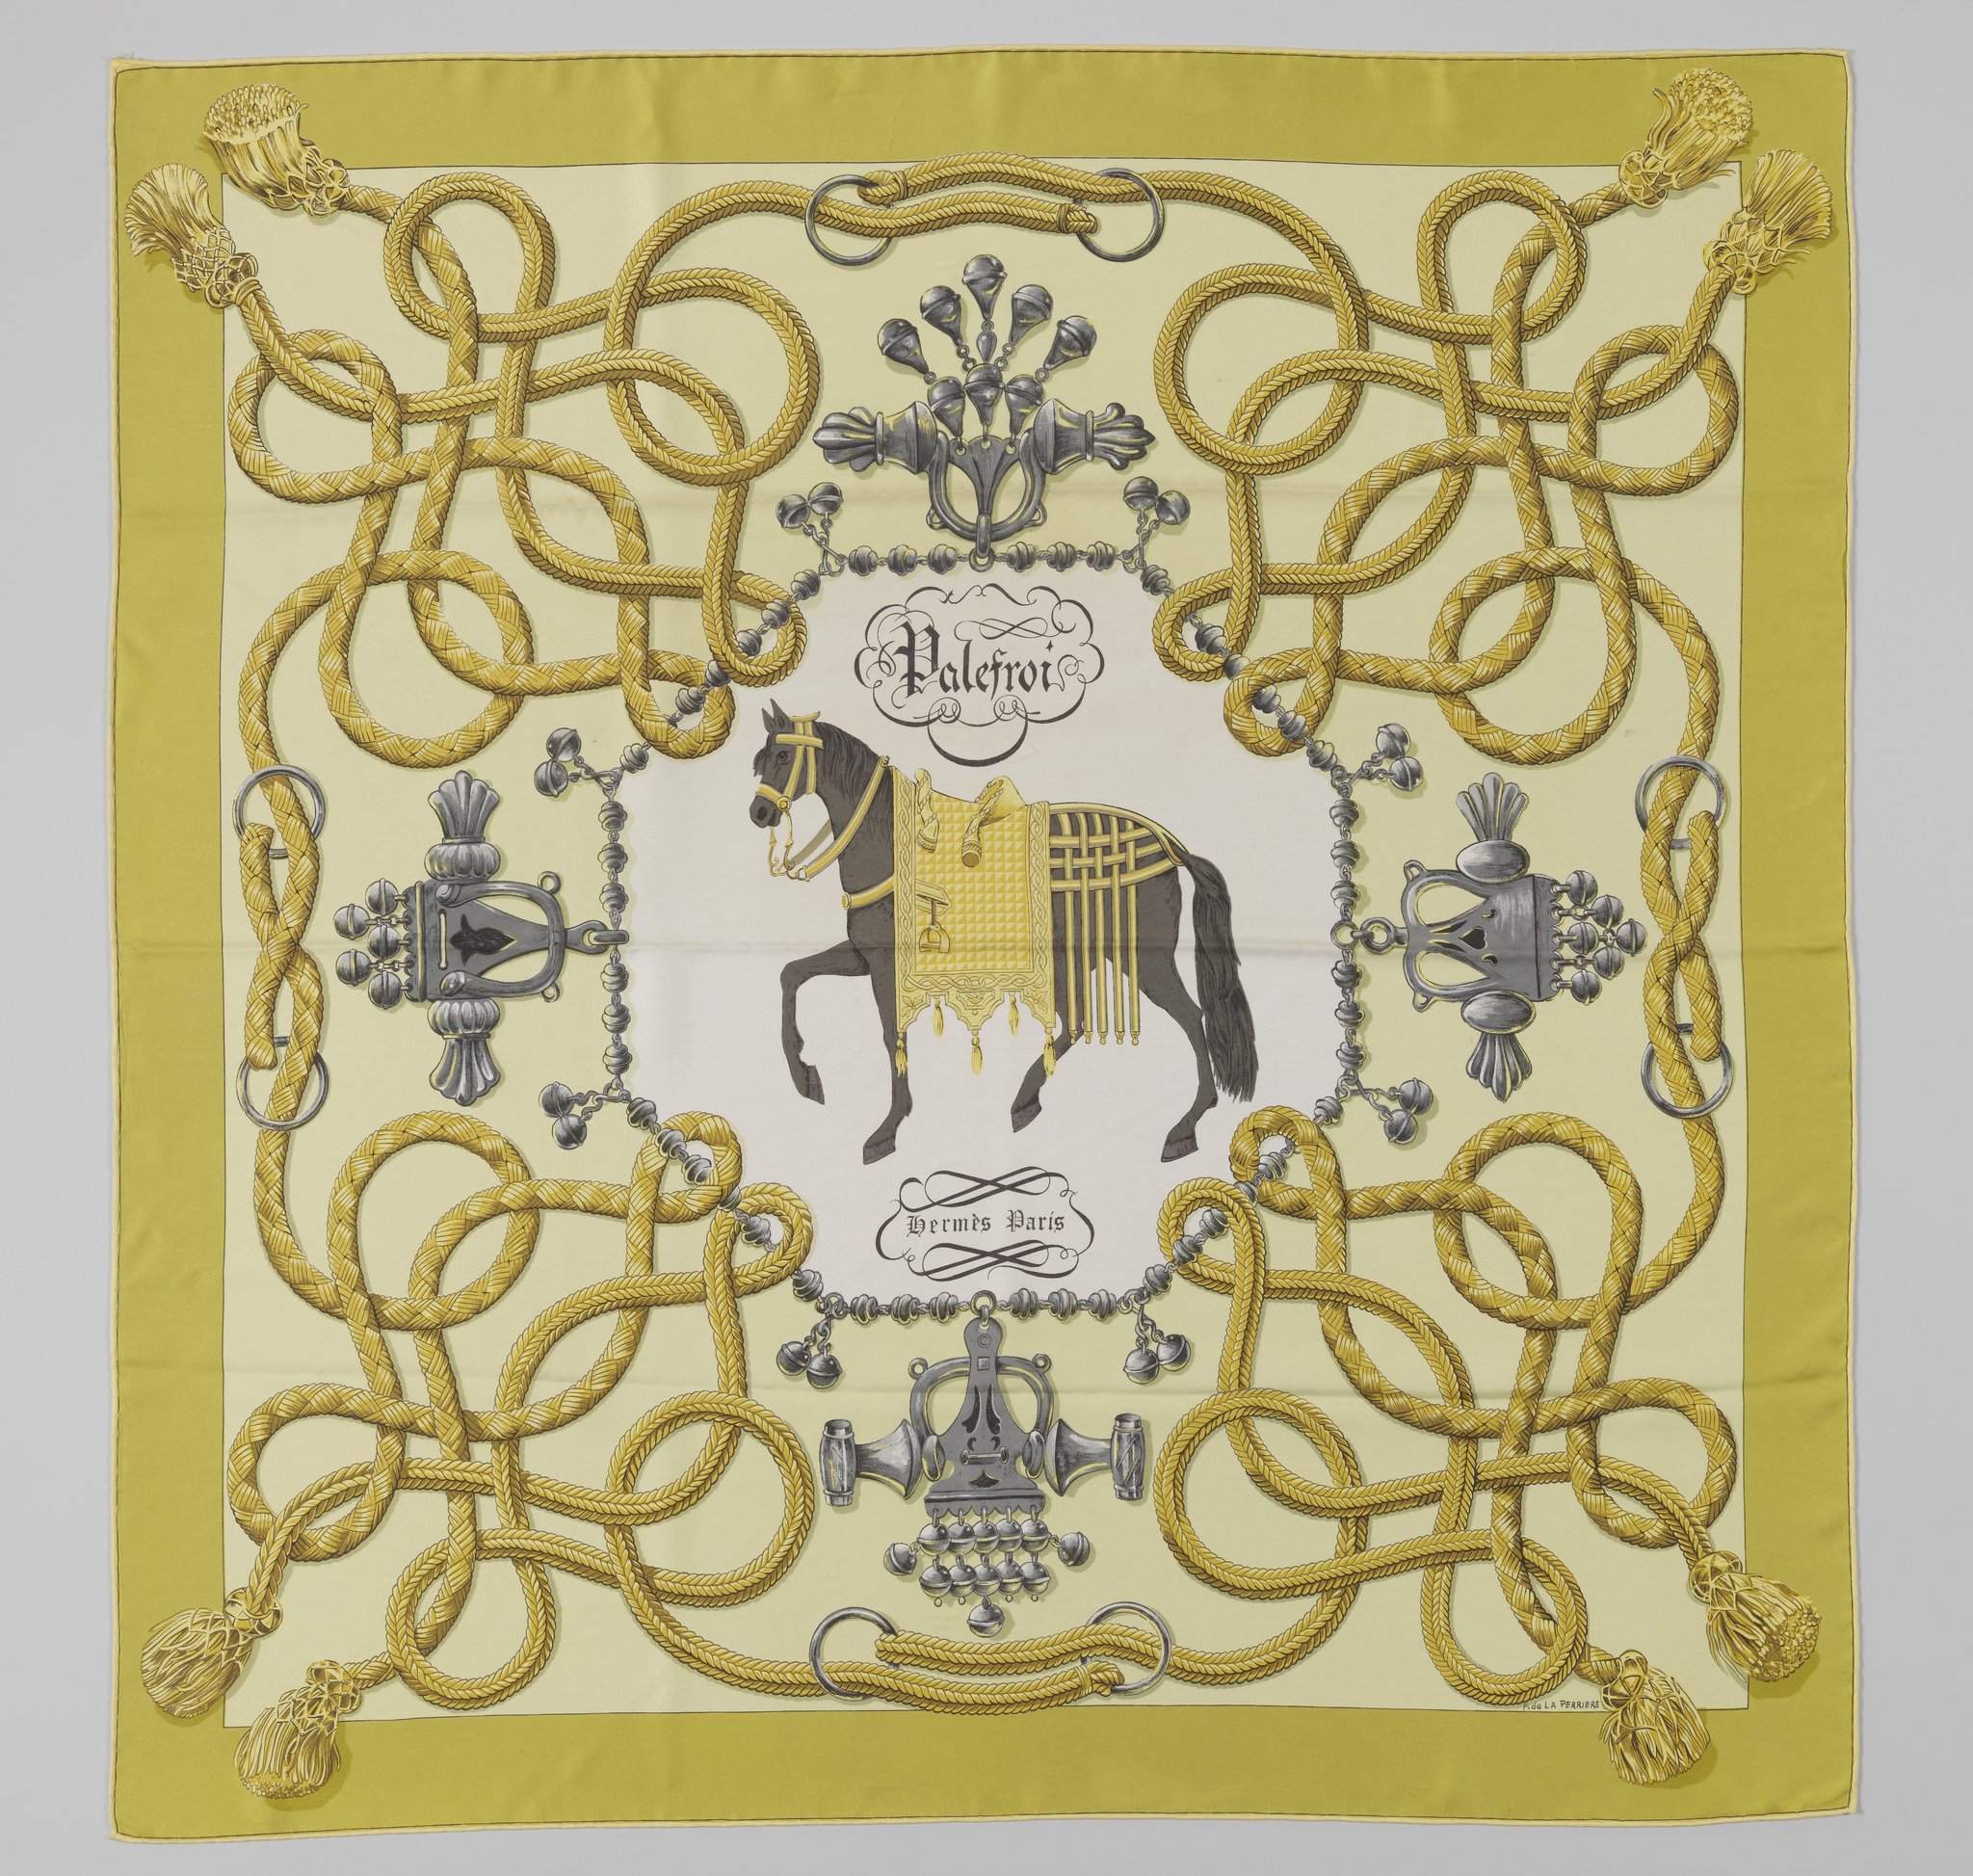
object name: clothing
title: Sjaal van gekeperde foulardzijde met een groen, geel en grijs getinte opdruk van hippische motieven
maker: françoise de la perrière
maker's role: designer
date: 1970-1980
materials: silk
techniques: printing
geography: paris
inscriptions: name: ‘Hermès Paris’, inscription: ‘Palefroi’, name: ‘F. de la Perriere’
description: Sjaal van gekeperde foulardzijde met een groen, geel en grijs getinte opdruk van hippische motieven. Model: vierkant. Rondom afgewerkt met een fijn, met de hand genaaid rolzoompje. Versiering: aan één kant bedrukt. In een centraal medaillon gevormd dor een metalen ketting met belletjes is een grijs paard met gele tijgage op een wit fond geplaatst. Boven het paard is 'Palefroi', er onder is 'Hermès Paris' in een kader gedrukt. De sjaal is in de rechter benedenhoek gesigneerd 'F. de la Perriere'. Adres: Hermès, Paris.